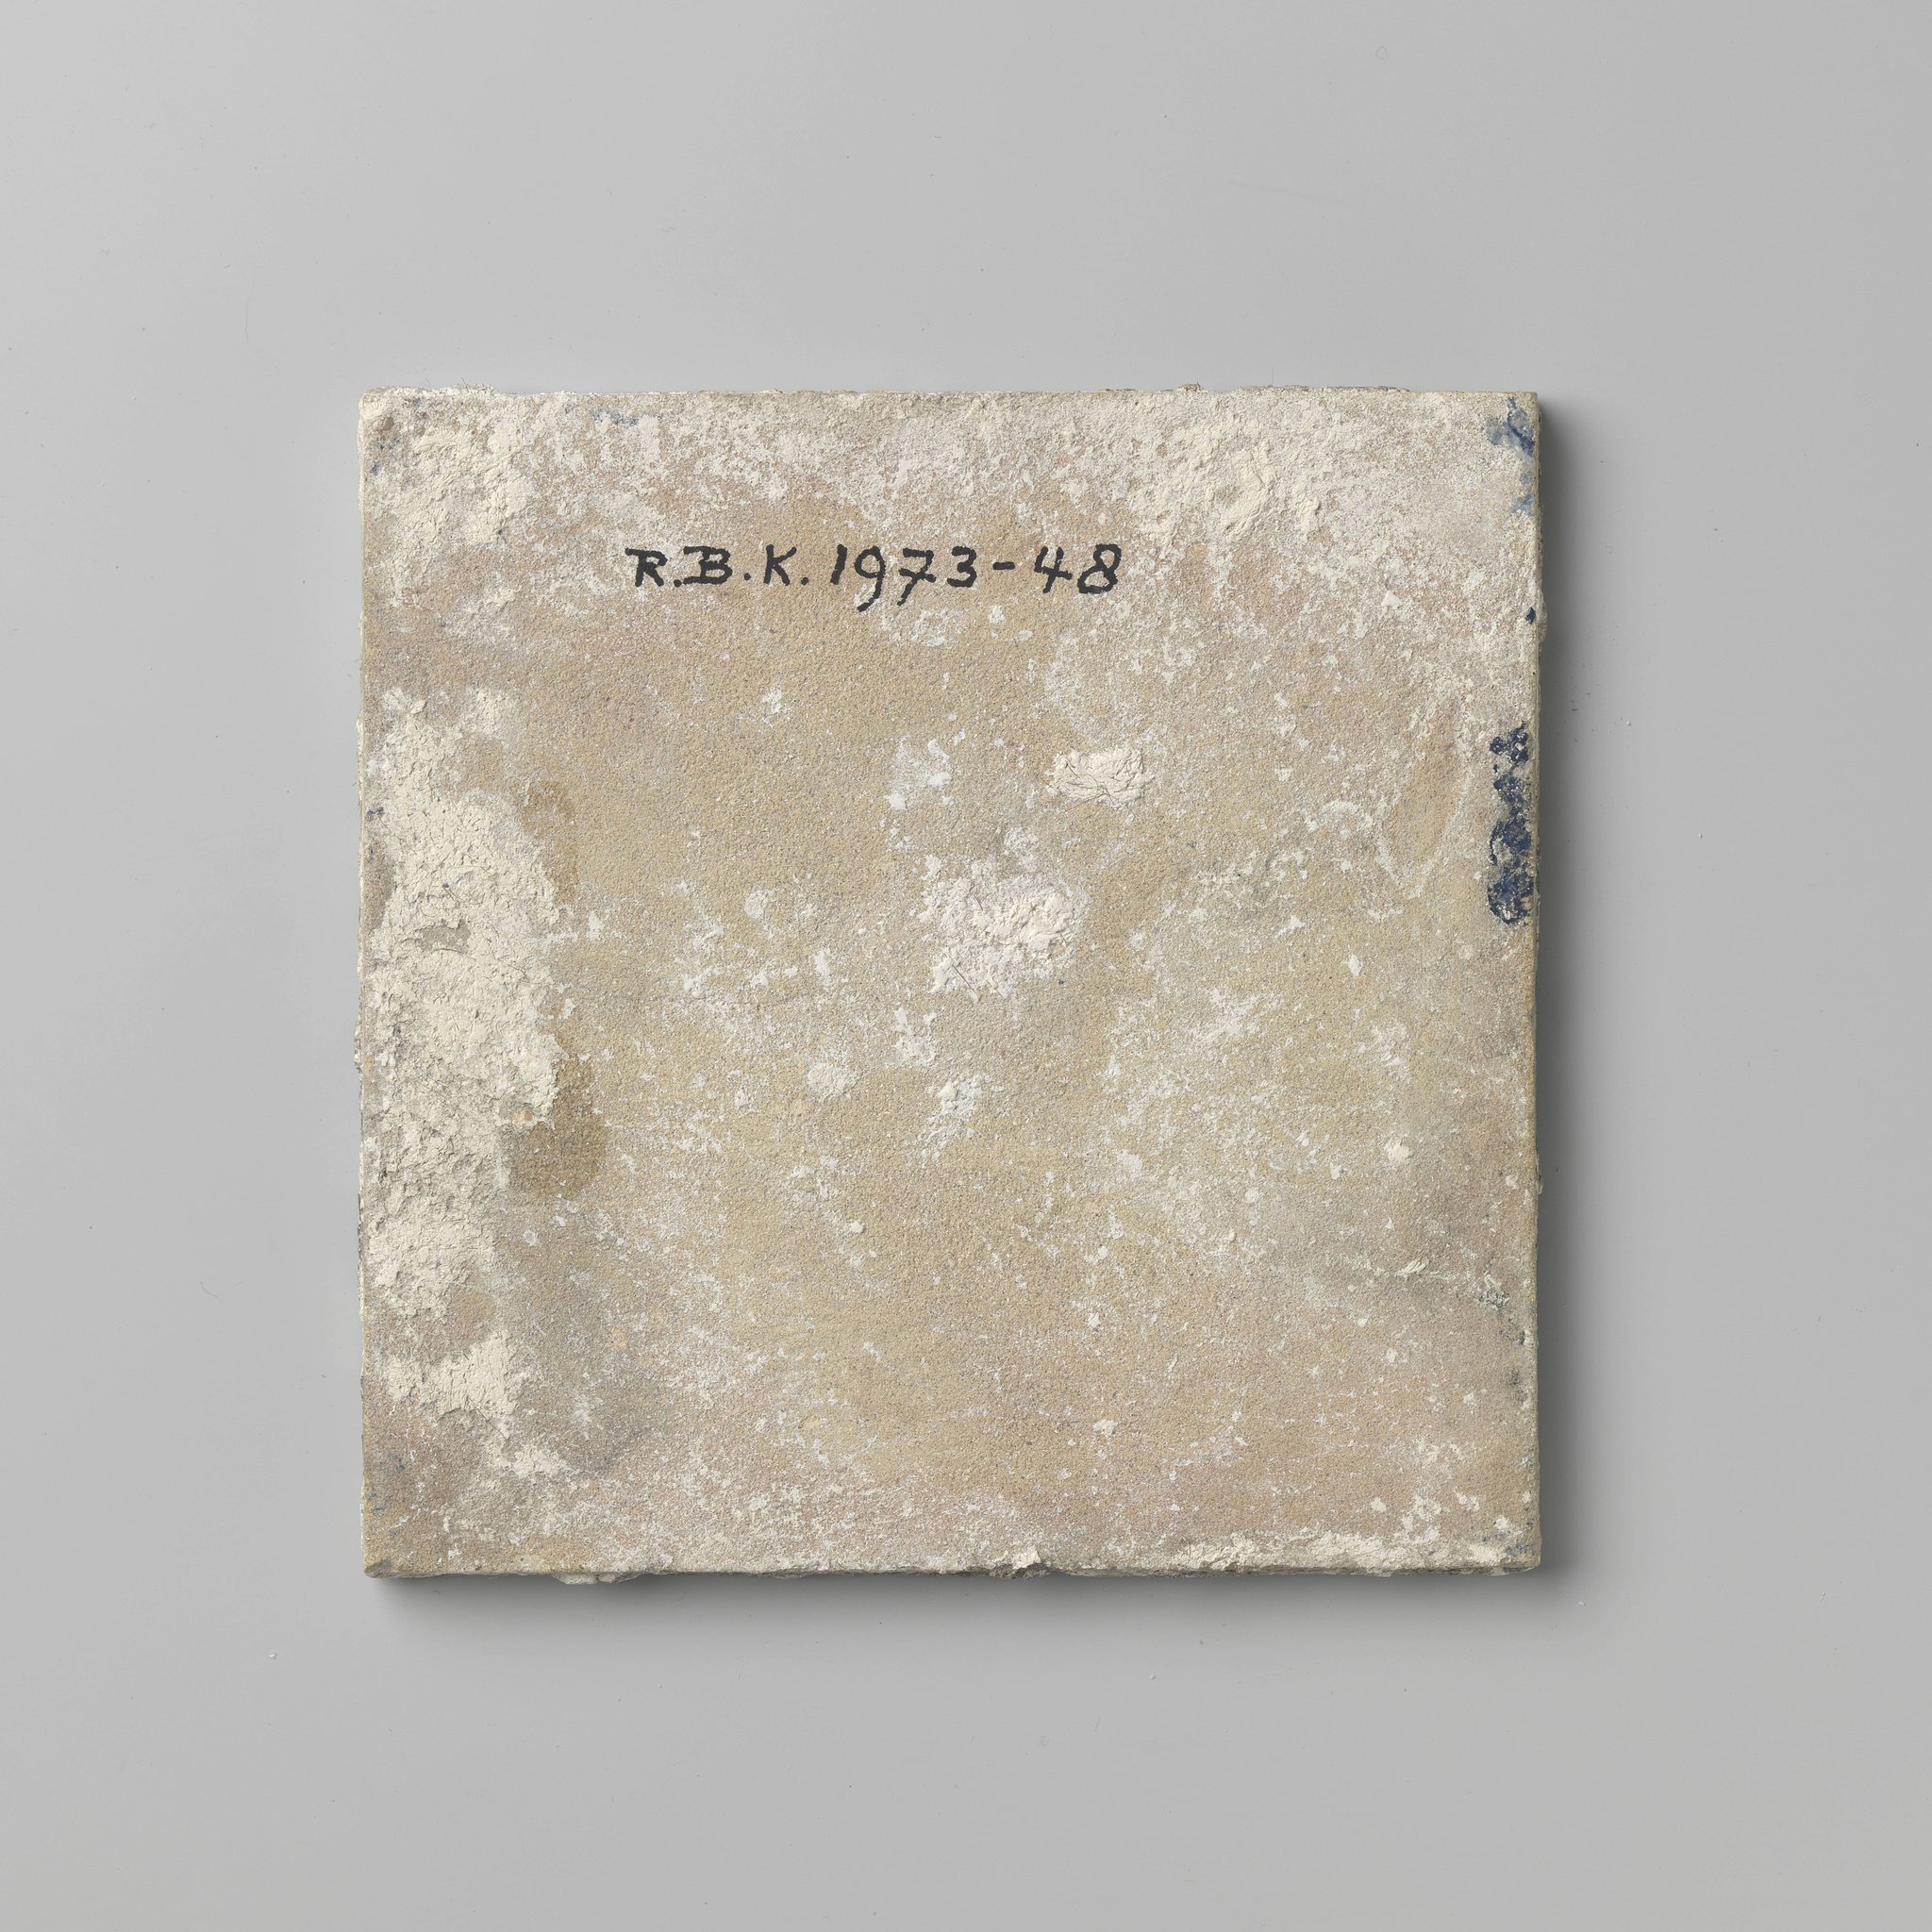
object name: tile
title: Tegel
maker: Anonymous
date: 1720-1760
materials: earthenware, glaze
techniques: maiolica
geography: london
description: Tegel met een veelkleurige (blauw, rood, geel en groen) geschilderde vaas met bloemen binnen een achthoek omgeven door blauw spatwerk. In de hoeken: uitgespaarde anjers.